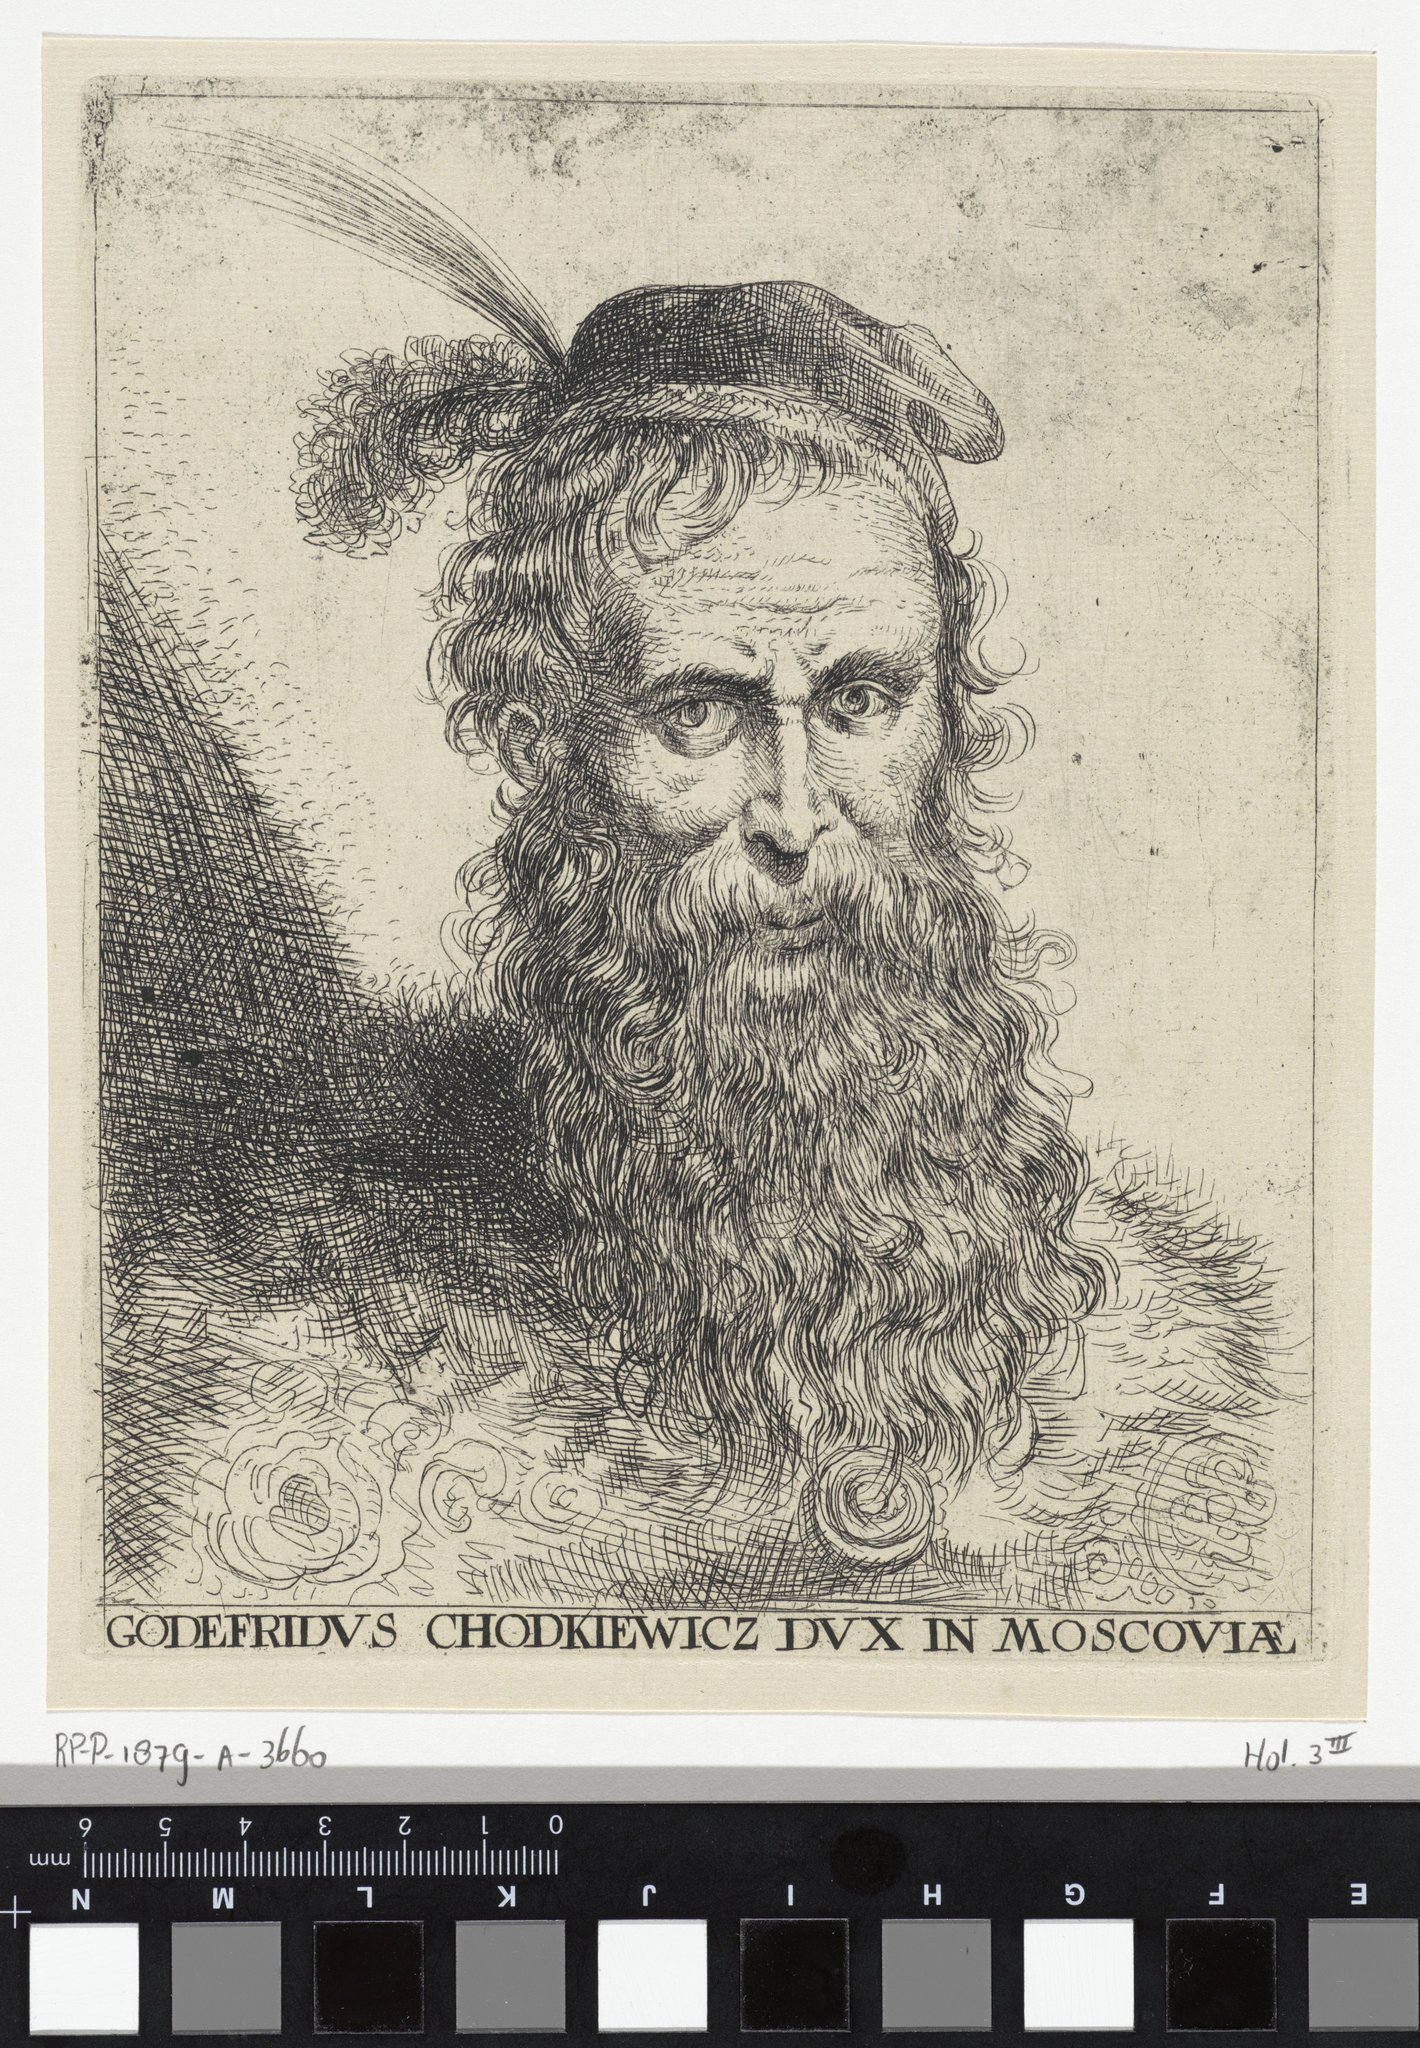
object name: print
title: Portret van Godfried Chodkiewicz, hertog van Moskou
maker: gerard seghers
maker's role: painter, print maker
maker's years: 1591-1651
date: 1591-1651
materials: paper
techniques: etching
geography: antwerp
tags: hertog, godfried chodkiewicz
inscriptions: collector's mark: Lugt 2228